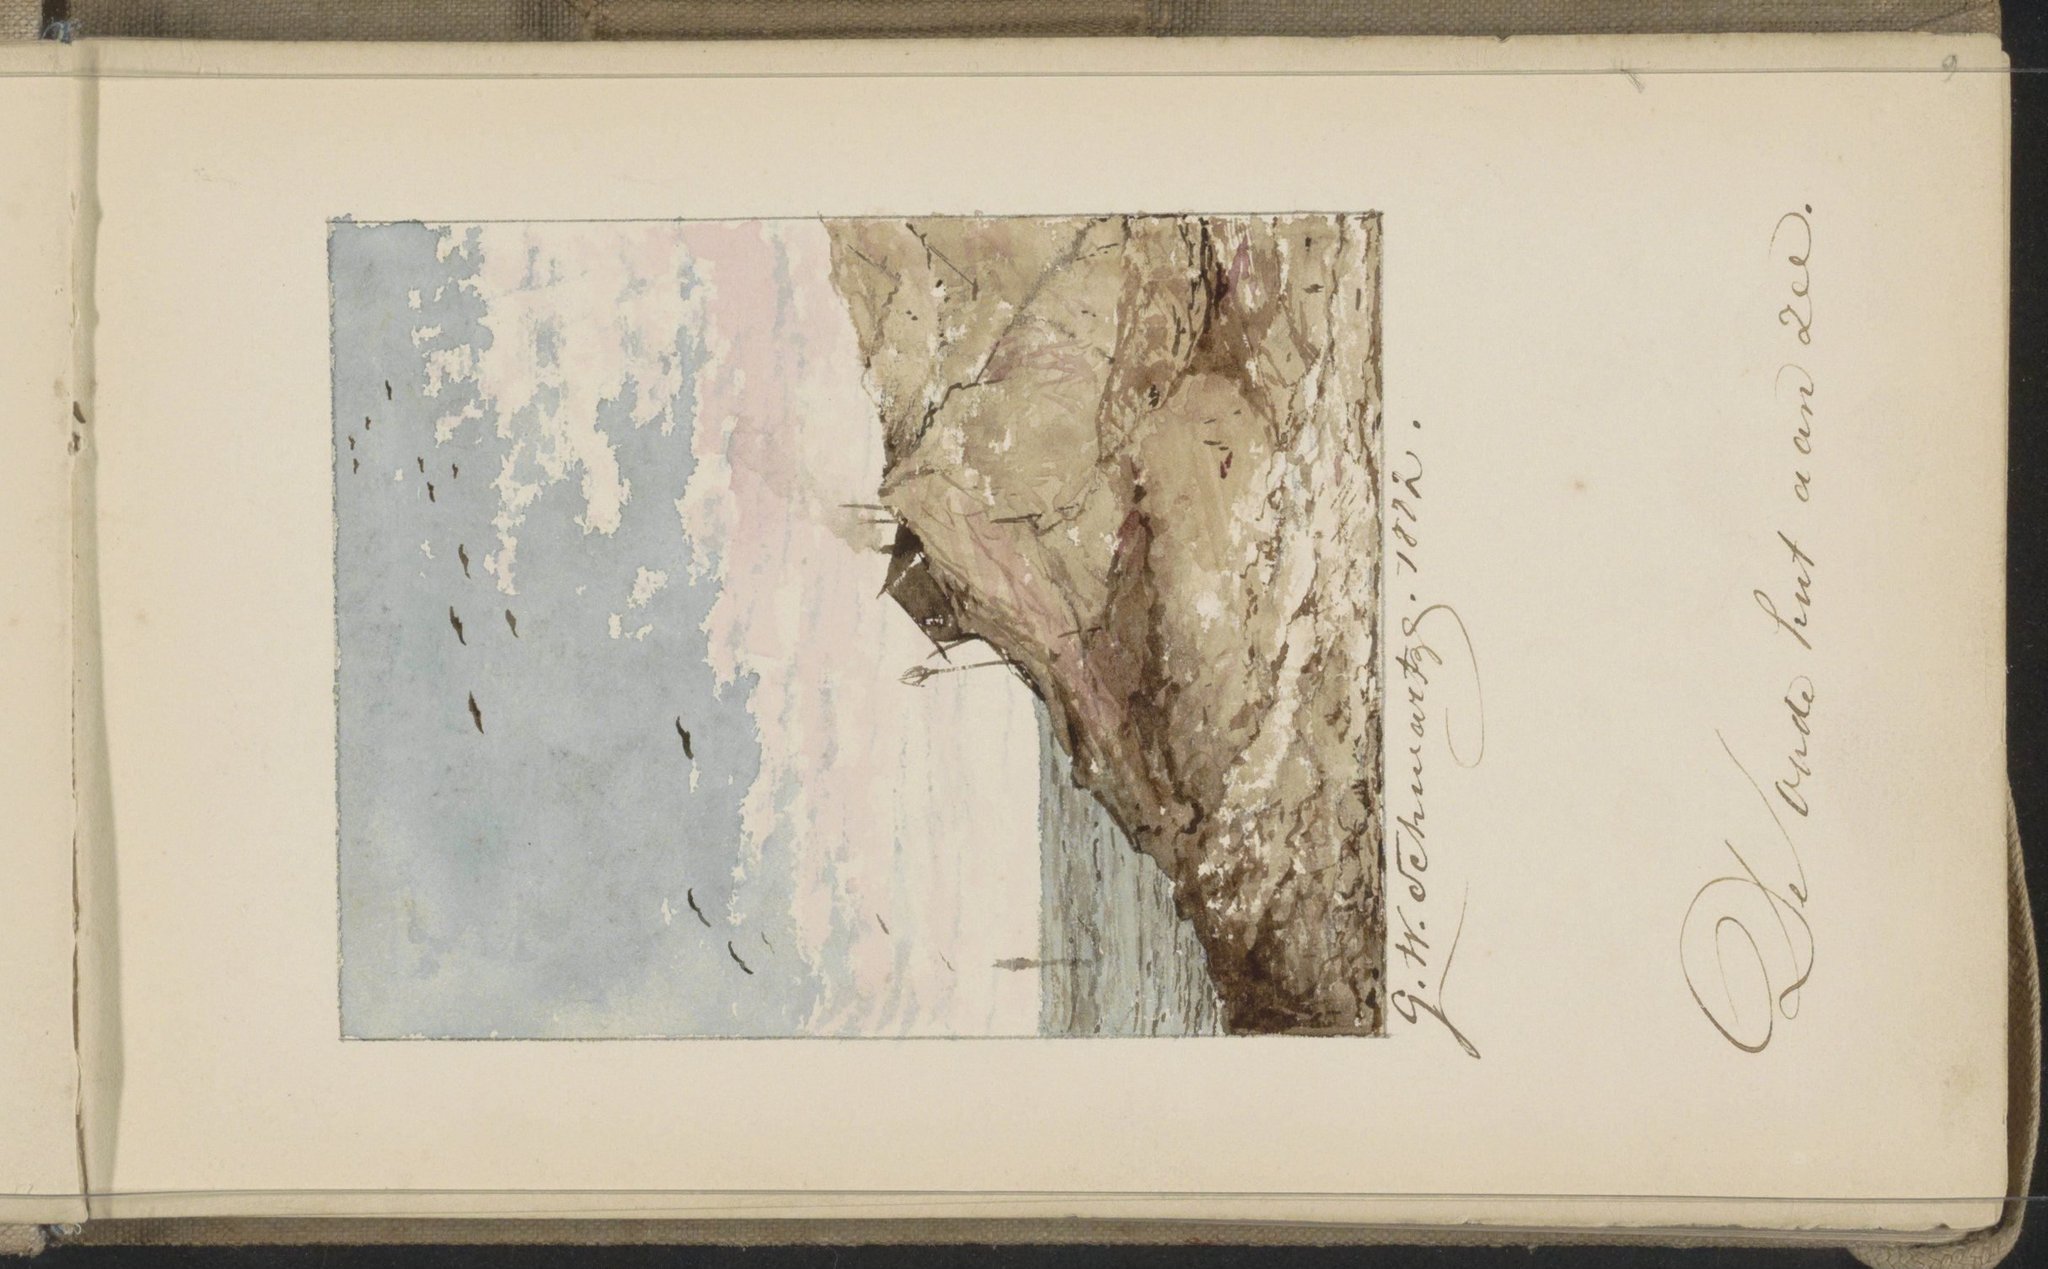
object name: sketchbook leaf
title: Hut op een rots aan zee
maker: george washington schwartze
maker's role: draughtsman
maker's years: 1857-1909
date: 1882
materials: ink, paper, pencil, watercolor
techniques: brush, pen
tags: hut, cabin, lodge, rocks, sea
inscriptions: signature and date: ‘G.W.Schwartze. 1882.’, title: ‘De oude hut aan zee.’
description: Tekening in een kader. Blad 9 recto uit een schetsboek met 54 bladen.